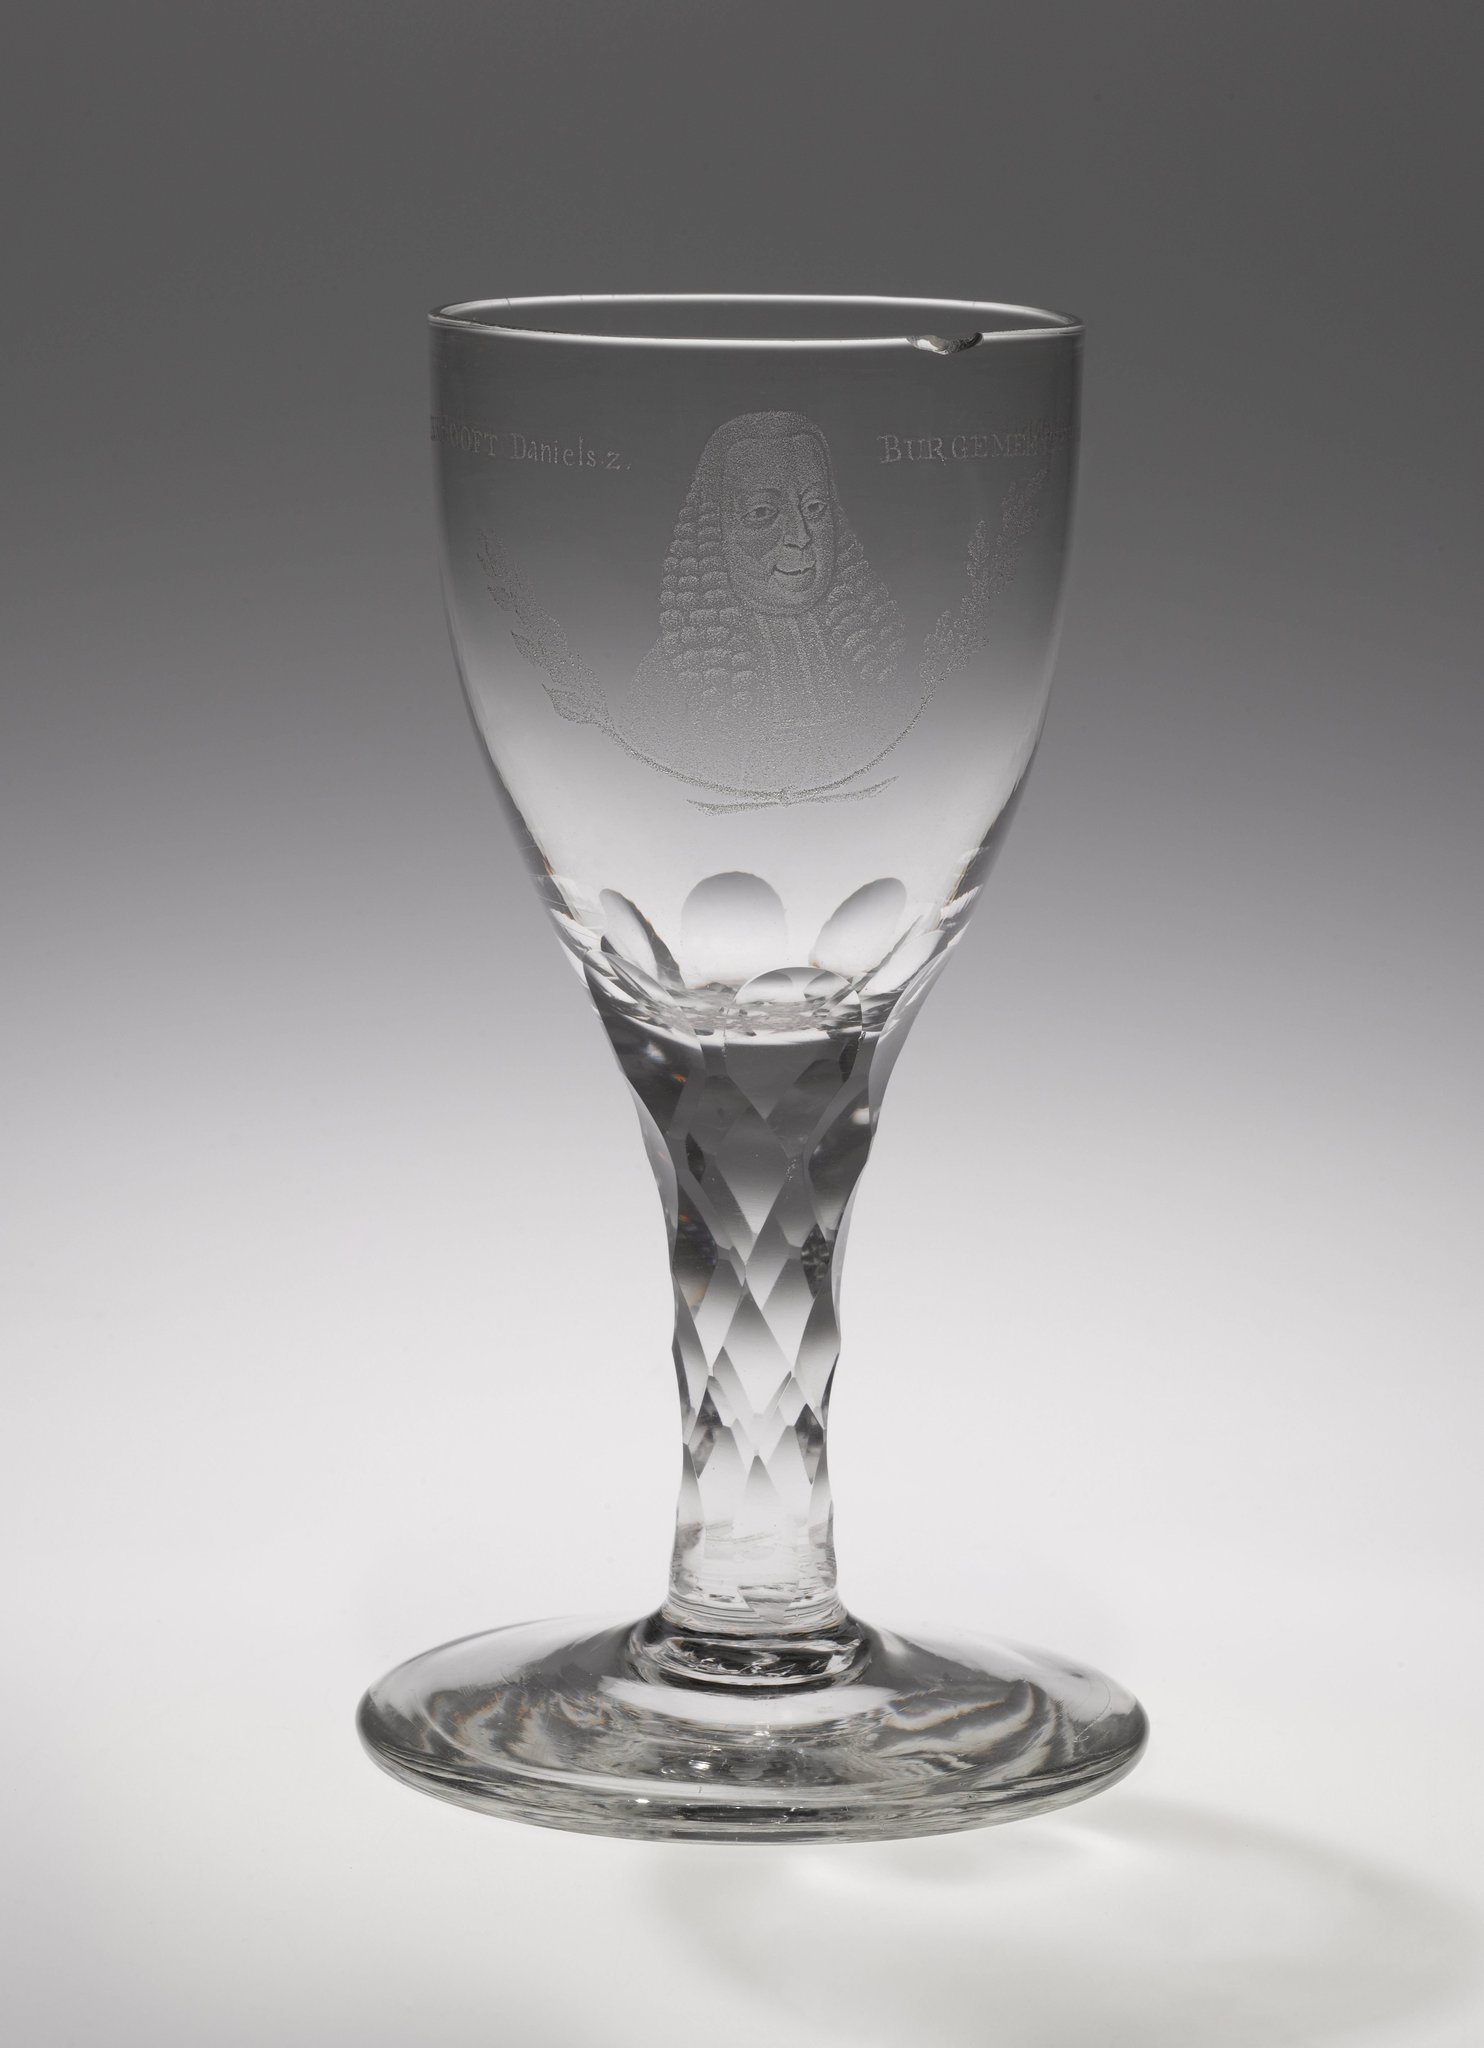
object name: goblet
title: Kelkglas met het portret van Hendrik Hooft Daniëlsz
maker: david wolff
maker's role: glasgraveur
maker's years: 1732-1798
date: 1780-1798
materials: glass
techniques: glassblowing, grinding, engraving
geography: northern netherlands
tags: amsterdam, mayor, hendrik danielsz. hooft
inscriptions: inscription, inscription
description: Conische voet. In facetten geslepen, zich verbredende stam, overgaande in een gebogen kelk.Op de kelk het portret van Hendrik Danielsz. Hooft (1716- 1794), burgemeester van Amsterdam, links begrensd door een lauertak en rechts door een tak eikeloof, die onder zijn verbonden. Boven het portret HENRIK HOOFT Danielsz. BURGEMEESTER der stad AMSTERDAM.